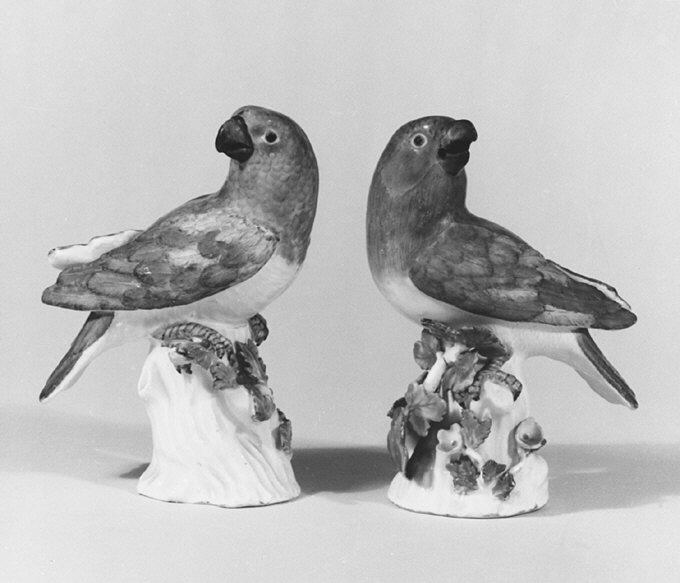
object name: figure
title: Parrot (one of a pair)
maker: meissen manufactory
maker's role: manufactory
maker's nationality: german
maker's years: 1710-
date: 1741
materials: hard paste porcelain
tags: parrots